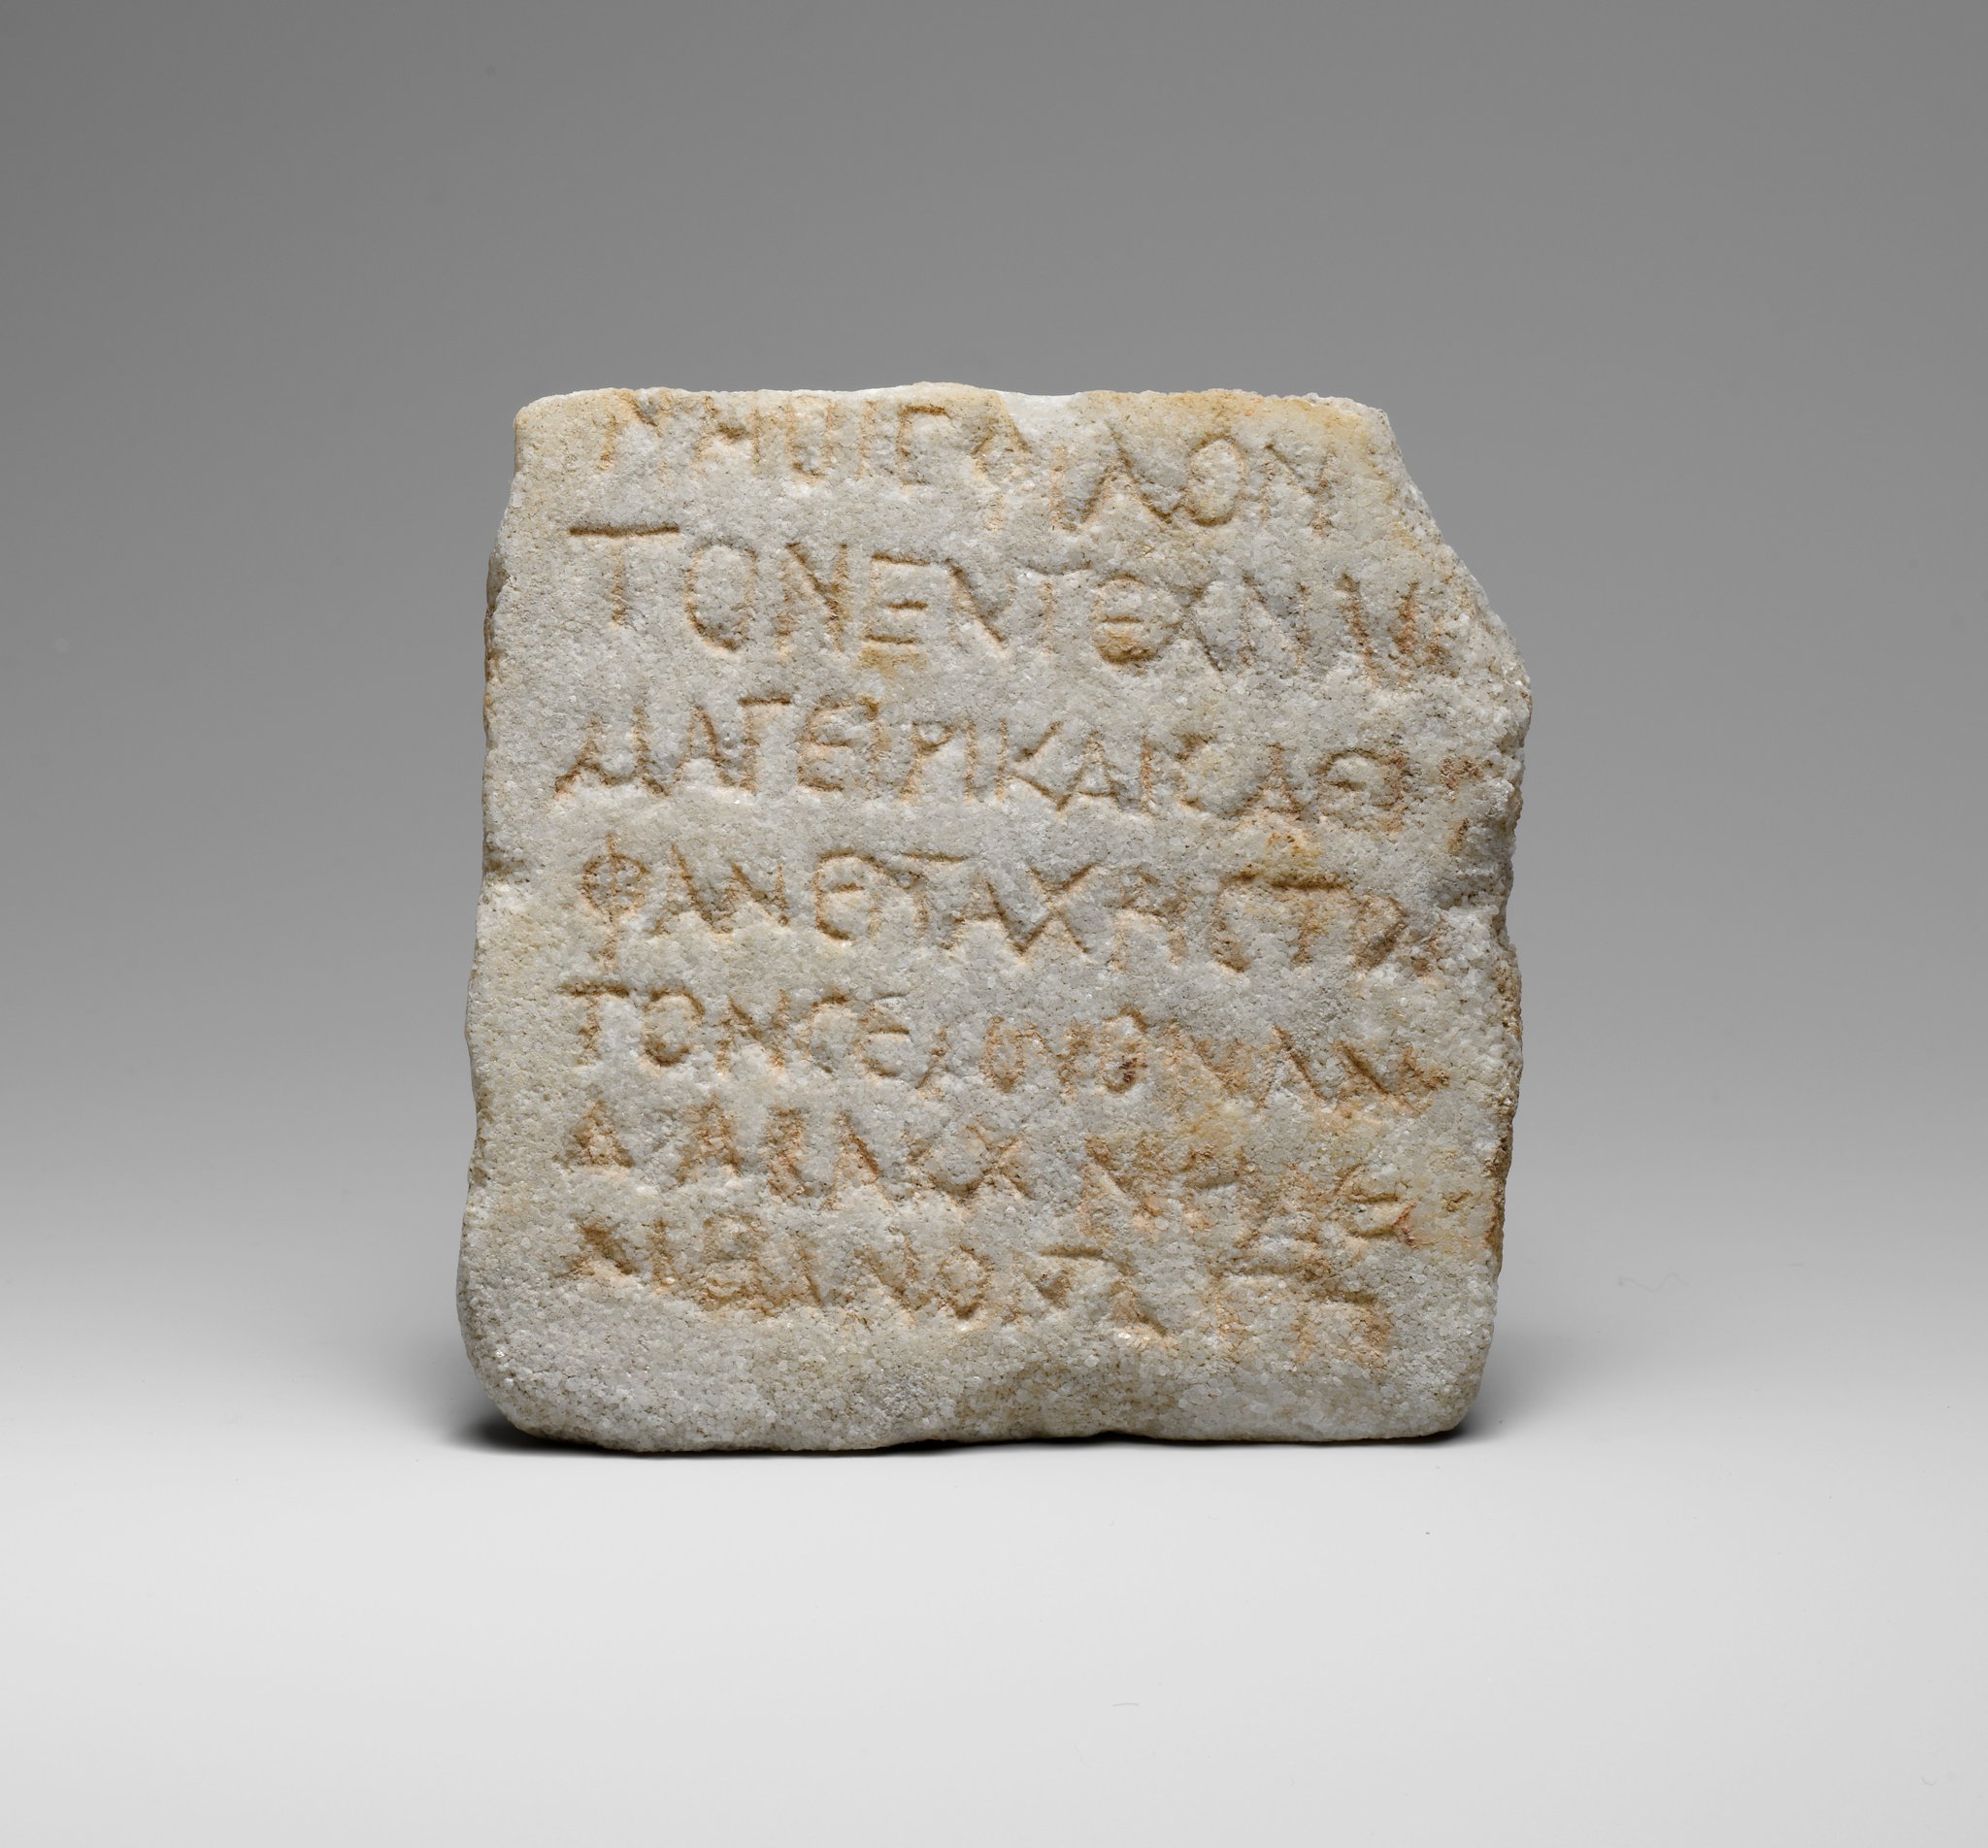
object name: tablet of bacchis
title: Inscribed marble plaque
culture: roman, cypriot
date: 101-300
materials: marble